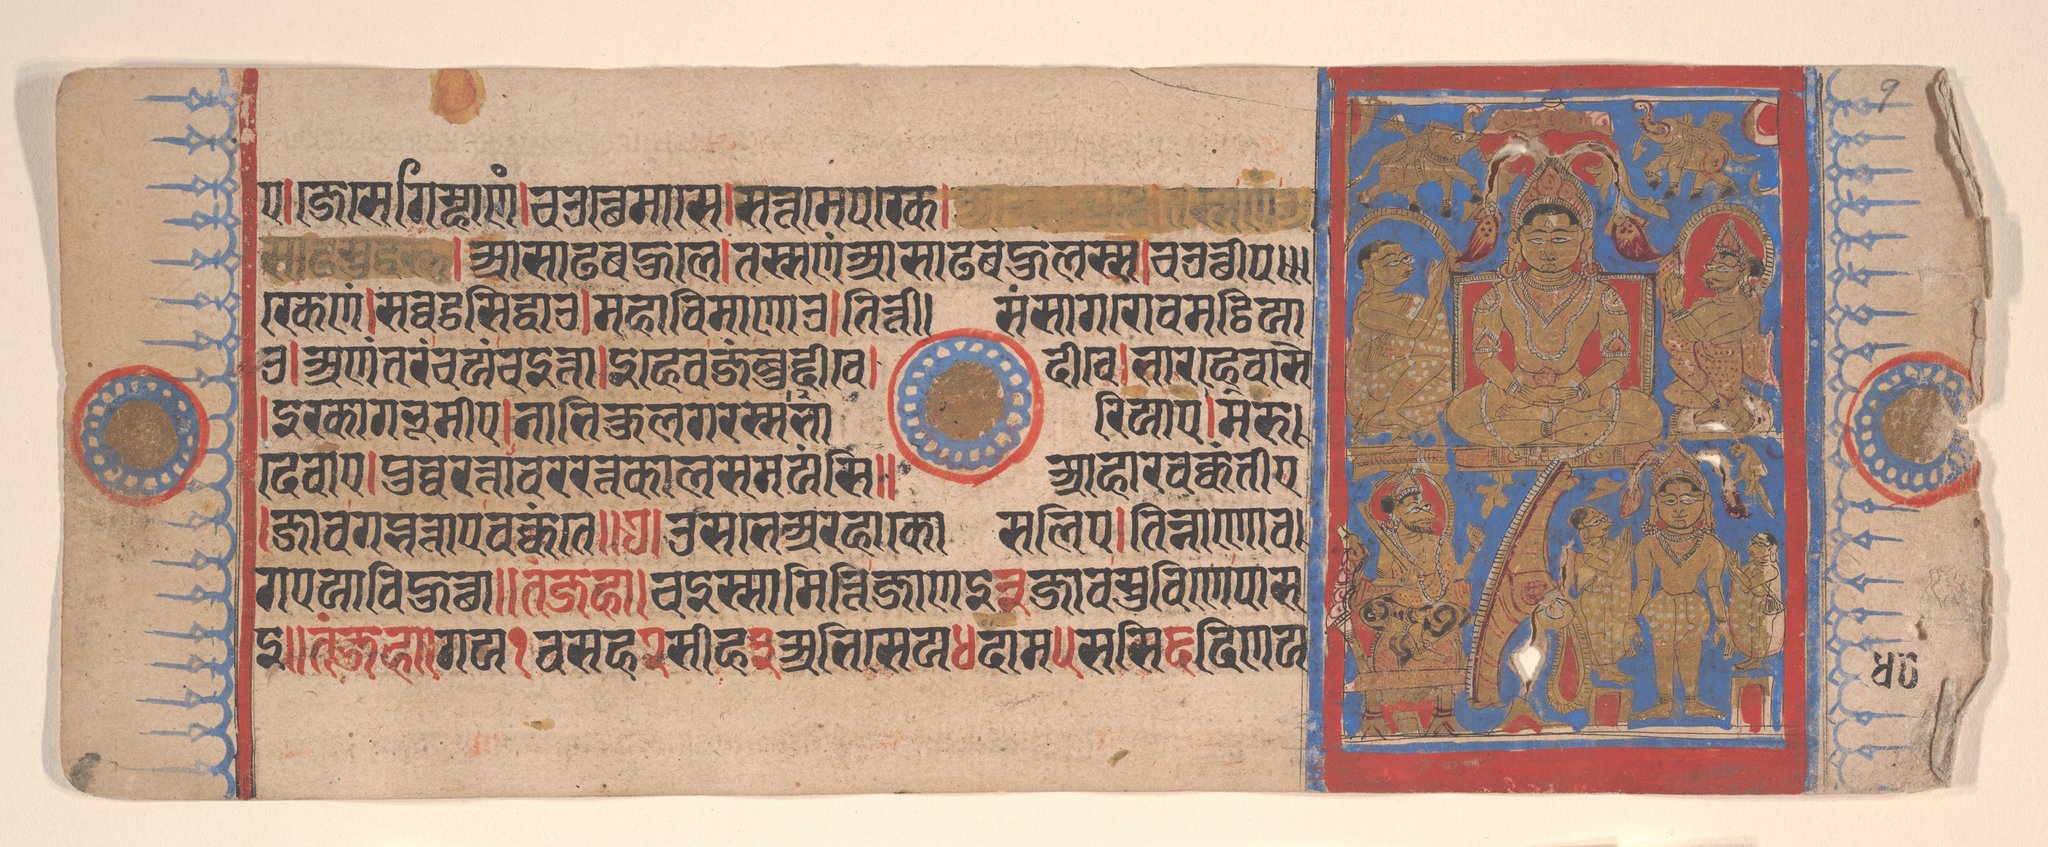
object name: folio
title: Leaf from a Kalpa Sutra (Jain Book of Rituals)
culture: indian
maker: bhadrabahu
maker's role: artist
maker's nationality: indian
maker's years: 356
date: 1401-1500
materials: gold, ink, paper, watercolor